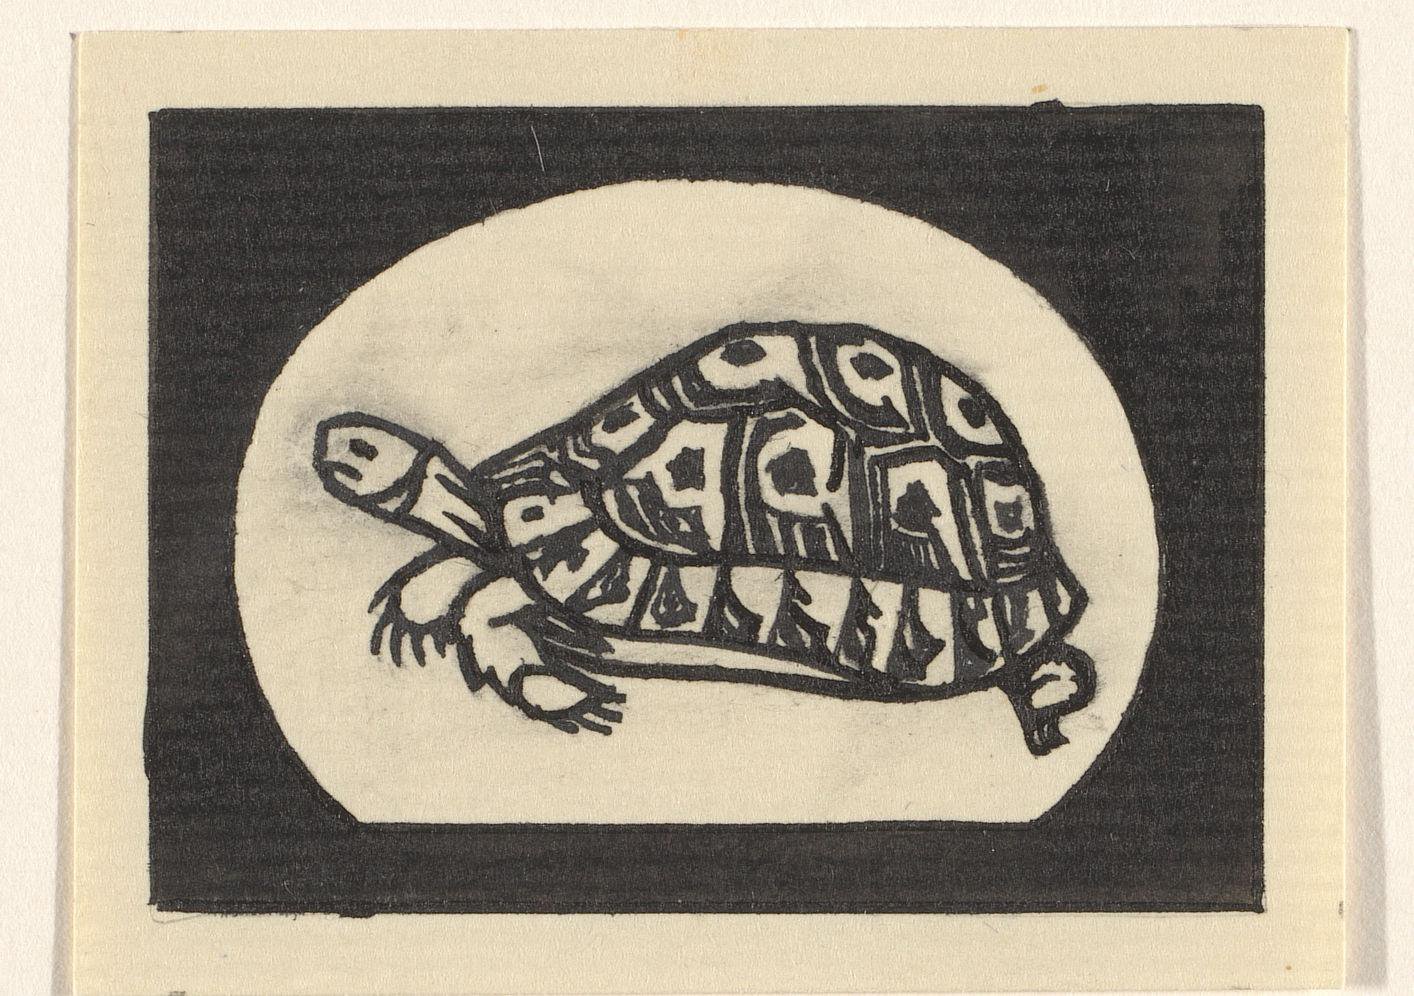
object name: drawing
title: Schildpad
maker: julie de graag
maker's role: draughtsman, print maker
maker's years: 1877-1924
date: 1887-1924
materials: ink, paper, pencil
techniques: brush, pen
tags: tortoises, turtles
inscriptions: number: ‘58’